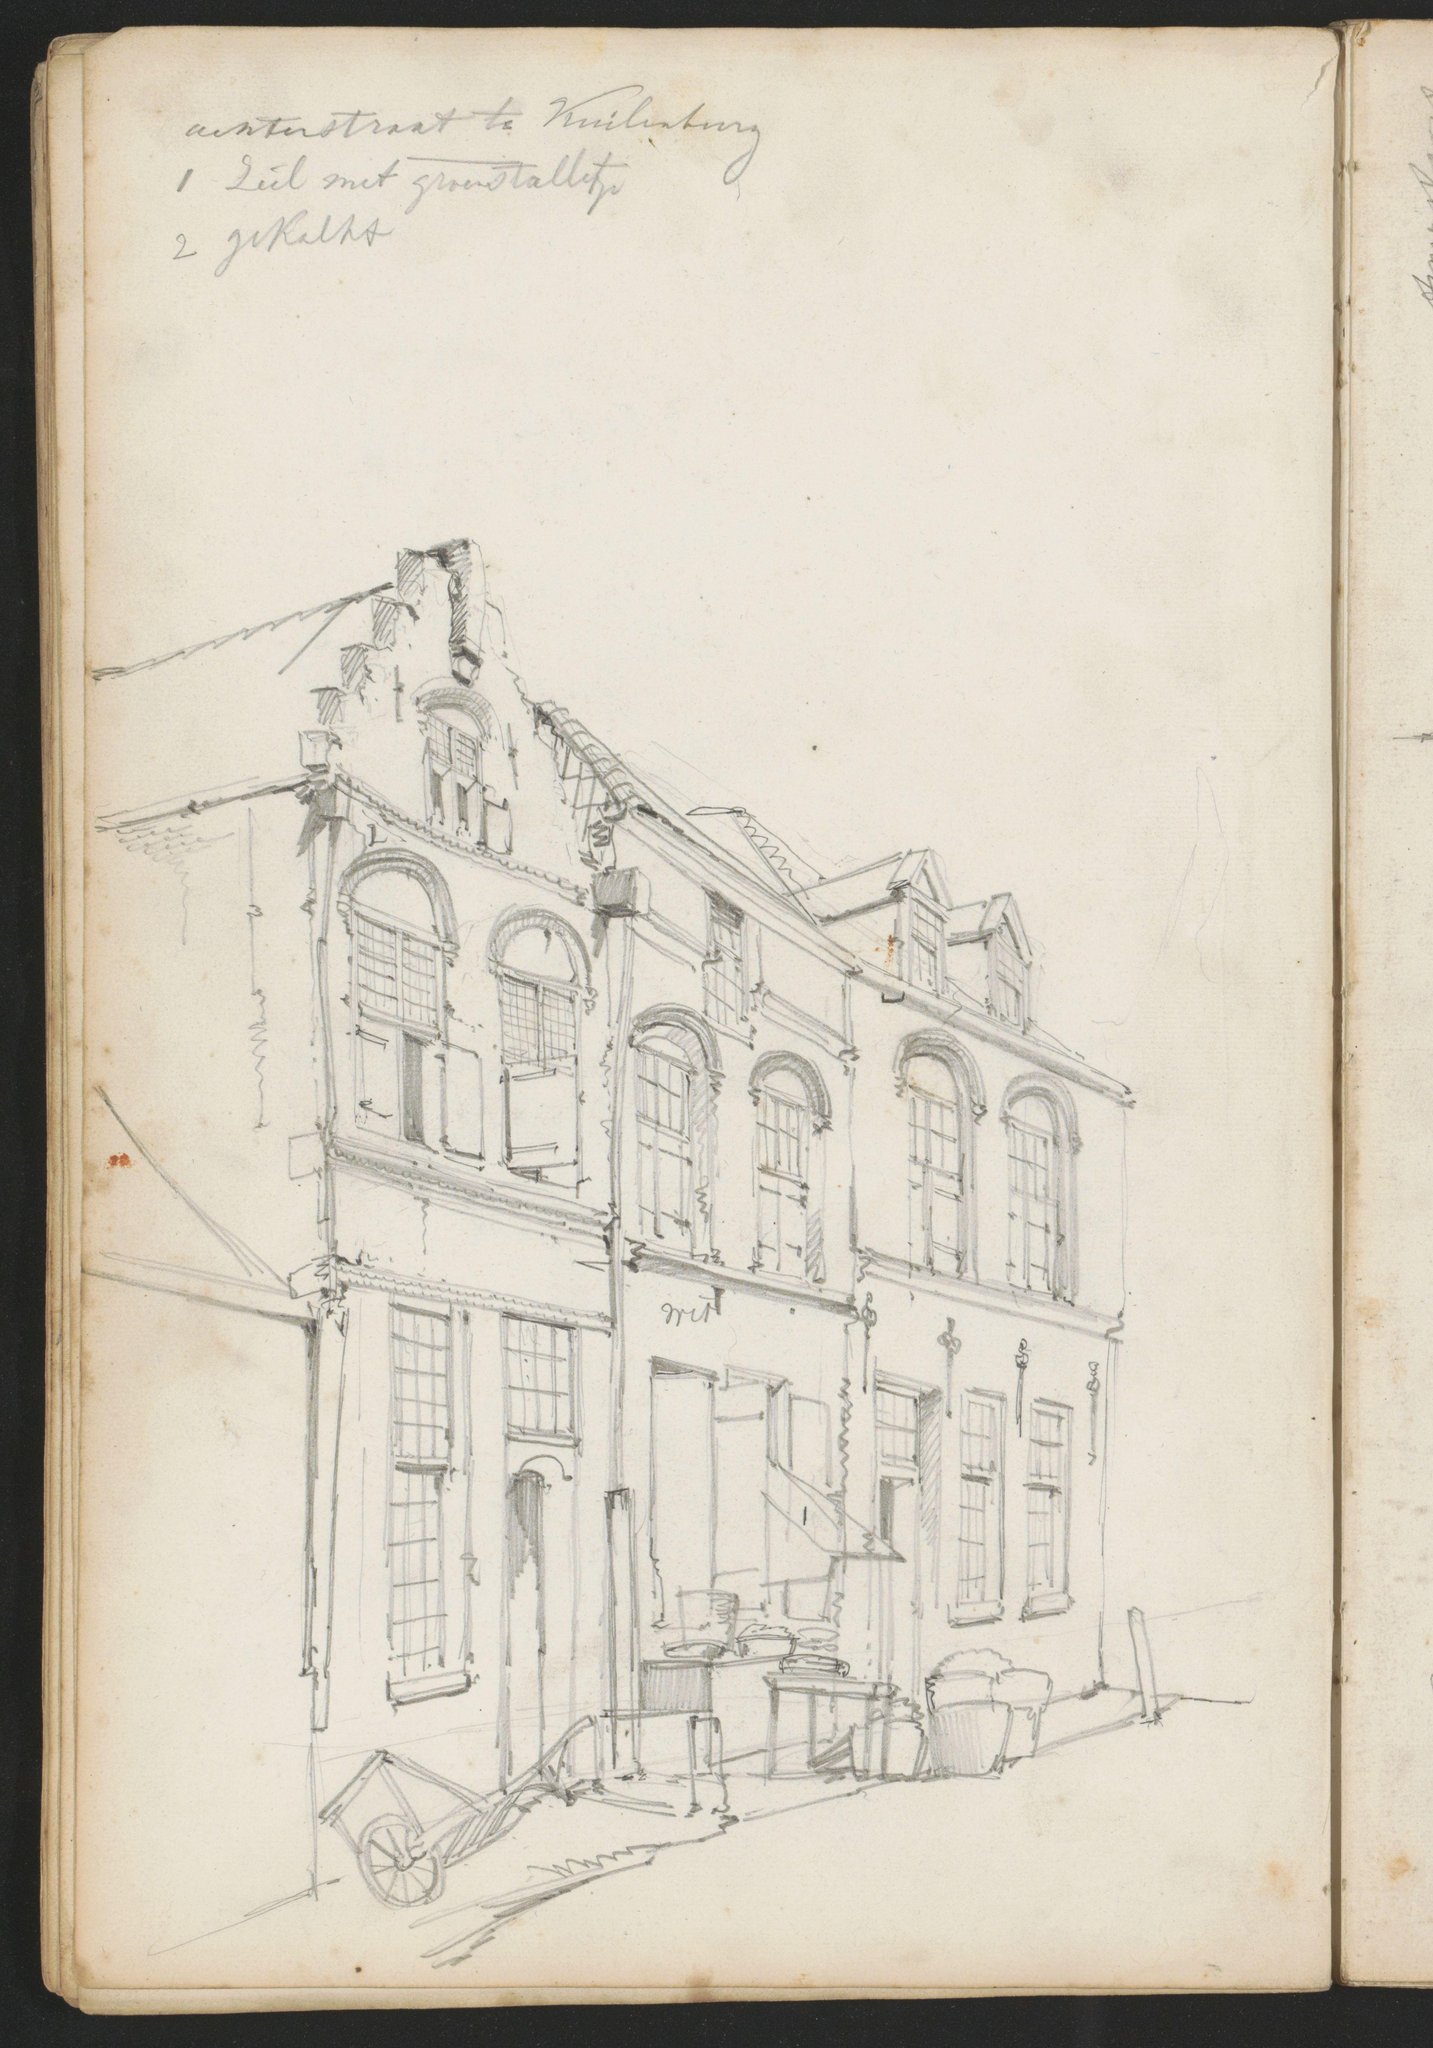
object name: sketchbook leaf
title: Achterstraat te Culemborg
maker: willem koekkoek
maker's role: draughtsman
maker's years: 1839-1895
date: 1849-1895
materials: paper, pencil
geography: culemborg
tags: stall, booth (~ market), street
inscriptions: annotation: ‘achterstraat te Kuilenburg/ 1 ziel met groenstalletje/ 2 gekalkt’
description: Op de straat staat een kar en een groentestal. Blad 18 verso uit een schetsboek met 42 bladen.